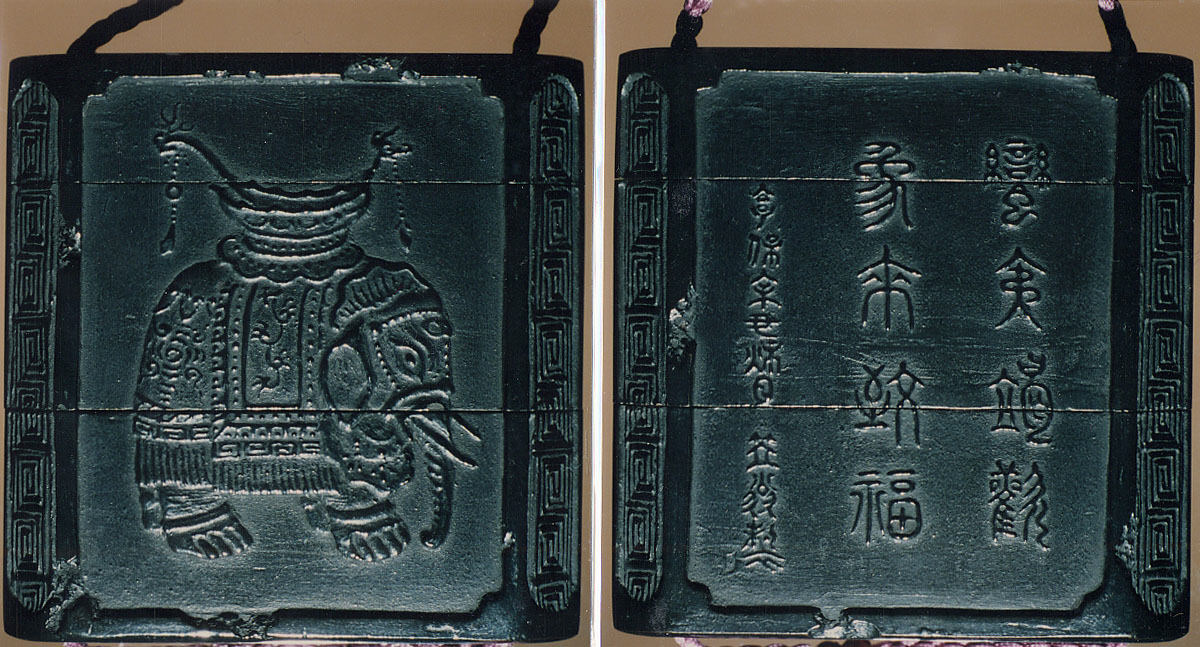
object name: inrō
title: Case (Inrō) with Design of Elephant (obverse); Chinese Characters (reverse)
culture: japanese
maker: fangshi mopu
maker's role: artist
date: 1721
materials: gold leaf, lacquer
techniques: hiramakie, roiro, maki-e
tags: elephants